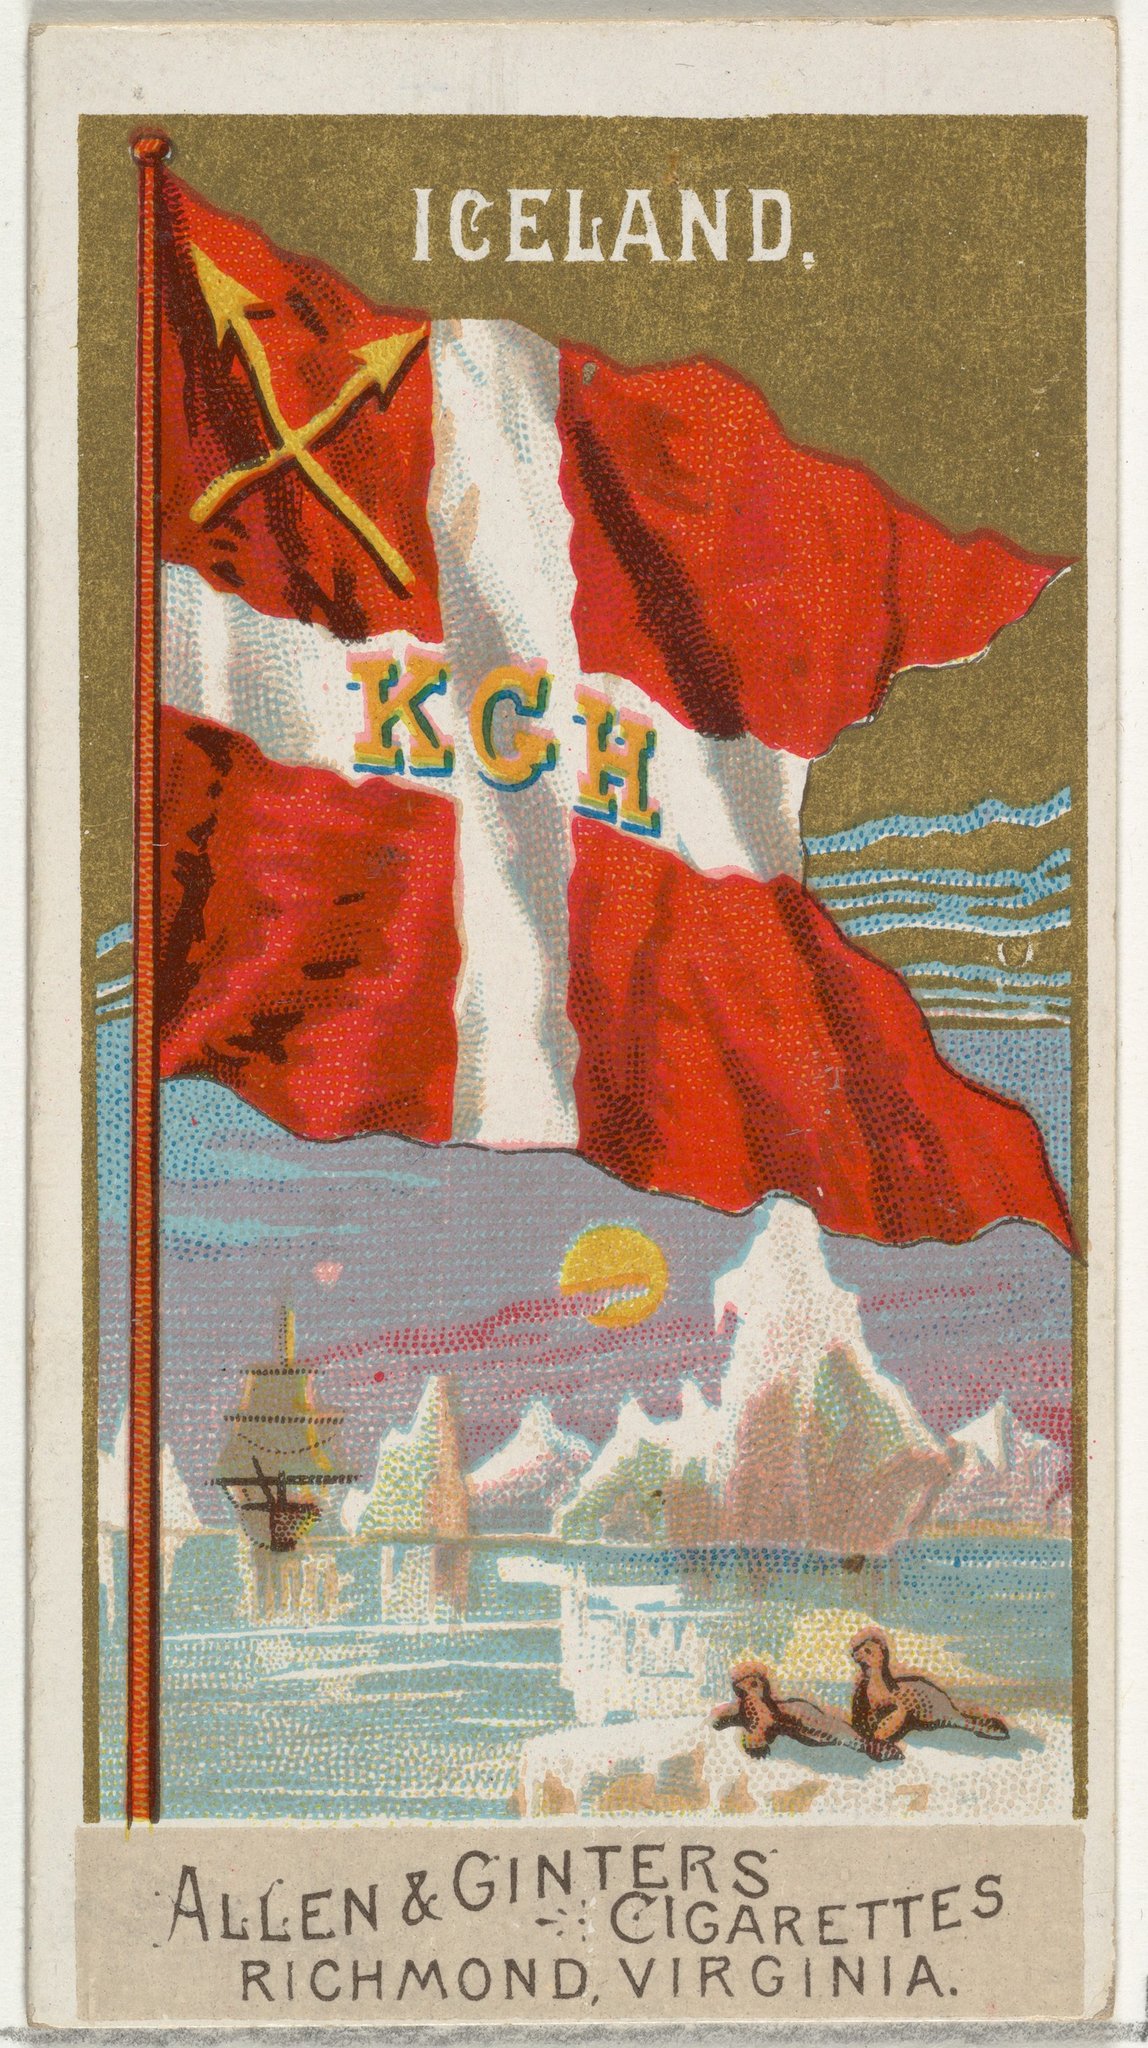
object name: print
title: Iceland, from Flags of All Nations, Series 2 (N10) for Allen & Ginter Cigarettes Brands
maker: allen & ginter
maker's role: publisher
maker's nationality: american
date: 1890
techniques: color lithograph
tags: flags